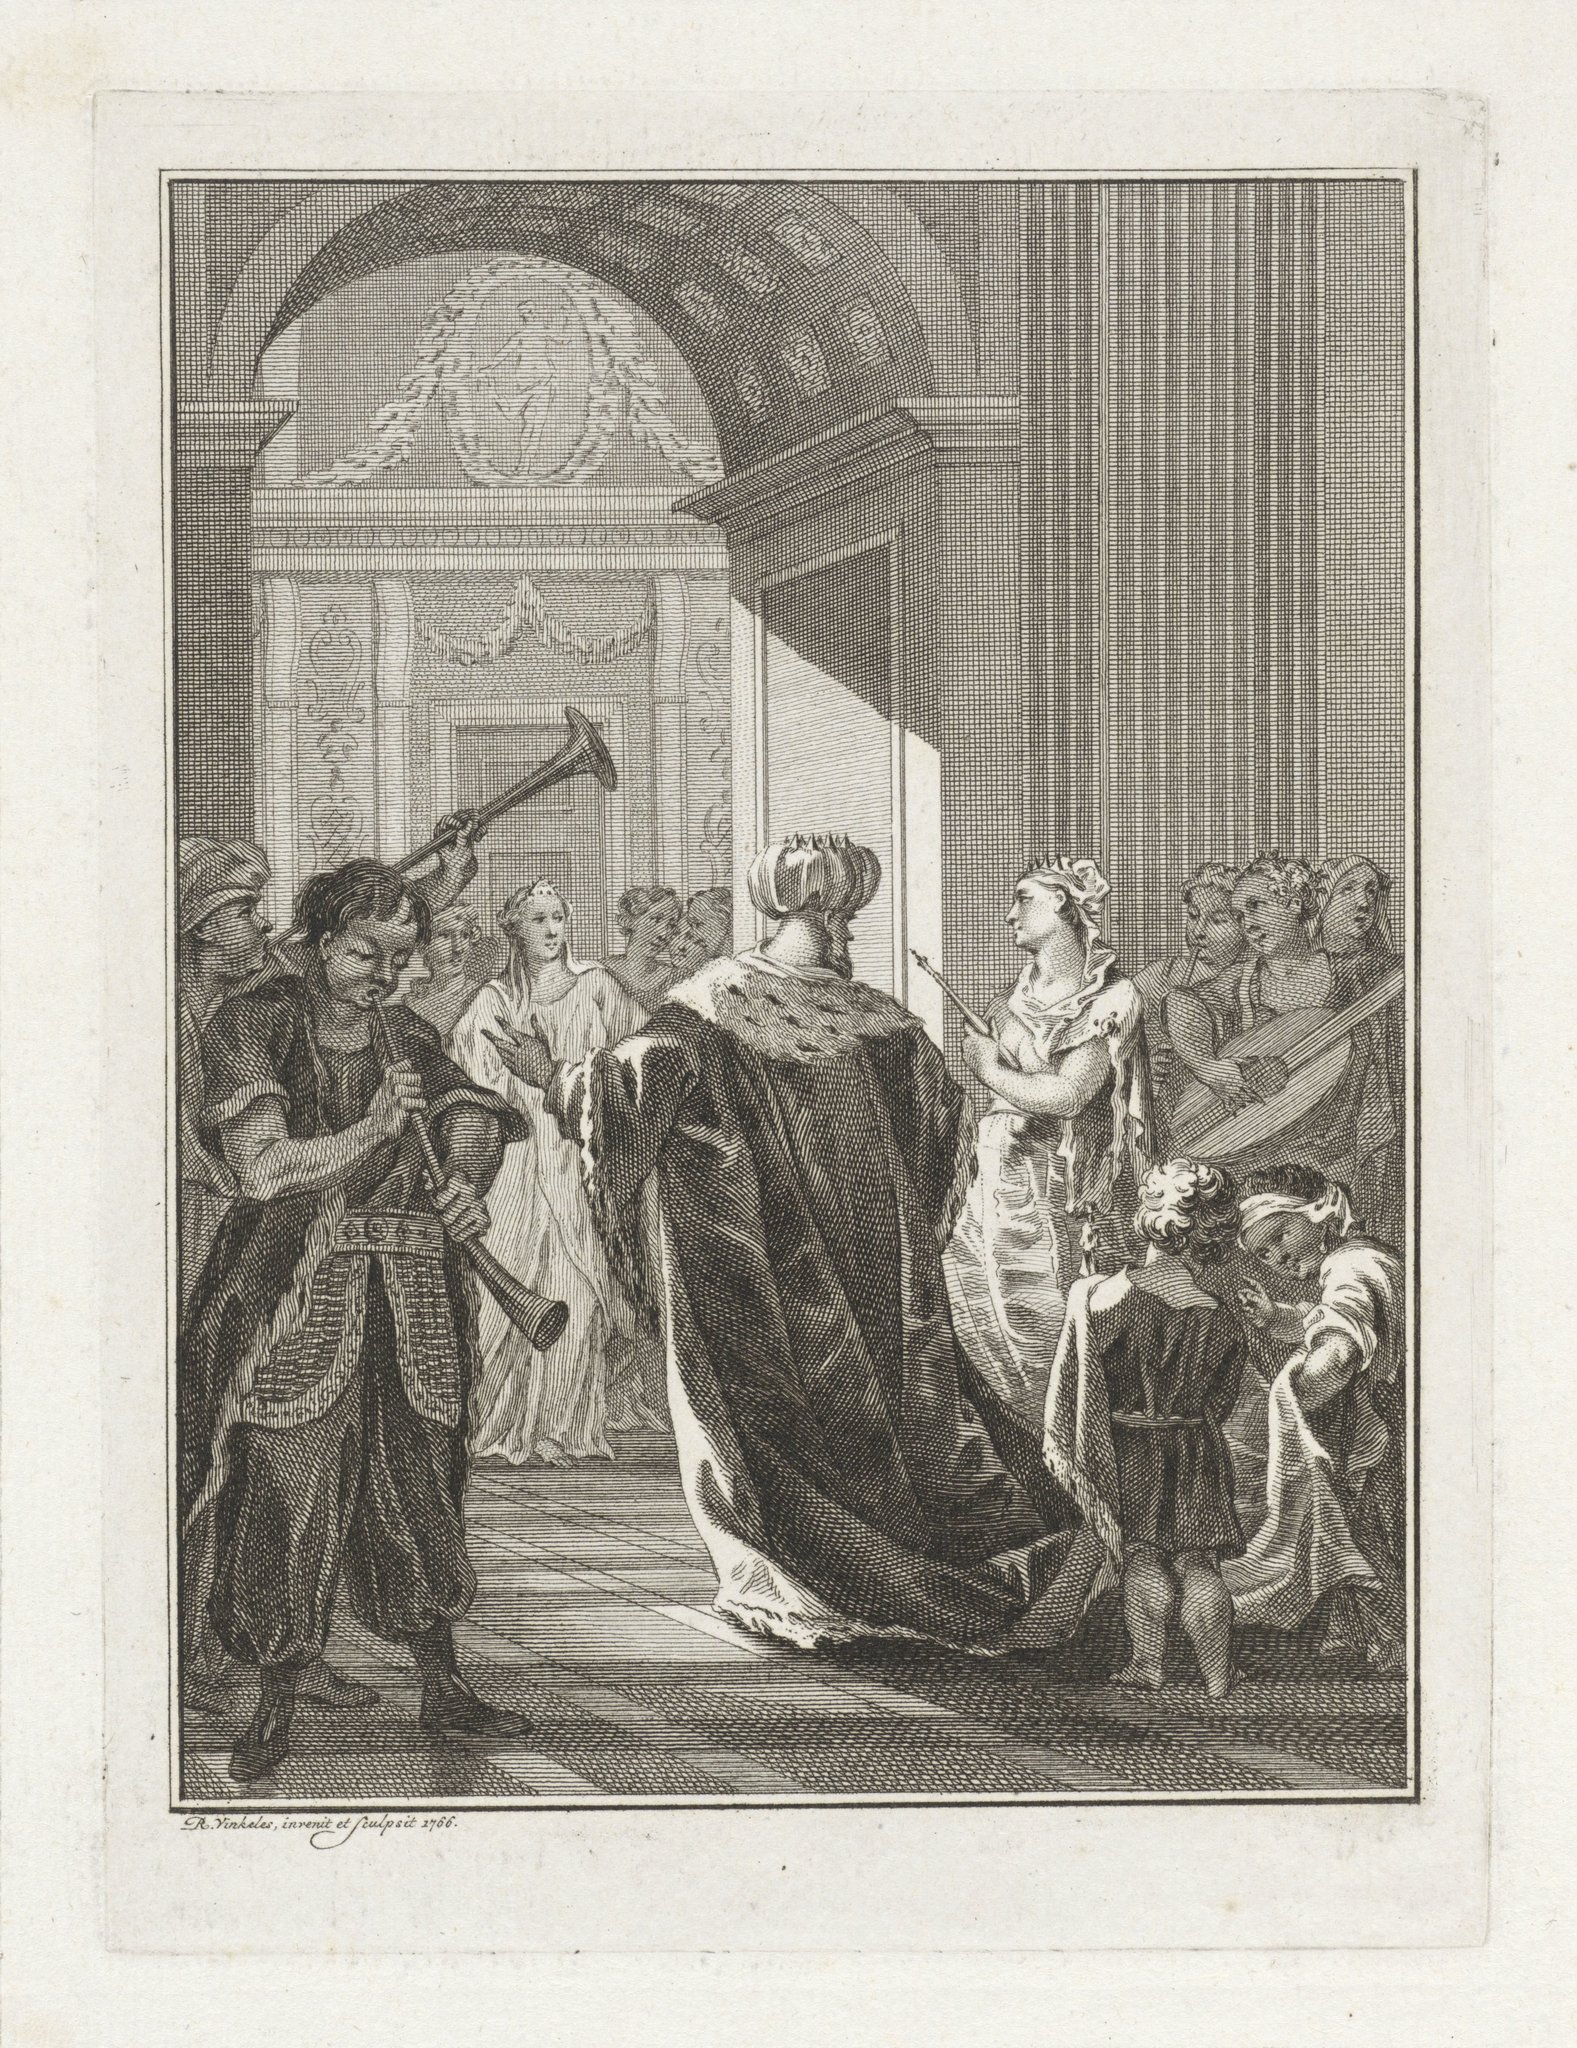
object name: print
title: Salomo en de koningin van Seba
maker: reinier vinkeles (i)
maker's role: draughtsman, print maker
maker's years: 1741-1816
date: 1766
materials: paper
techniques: engraving, etching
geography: amsterdam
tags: homage to solomon: the queen of sheba gives solomon gold, precious stones and spices, the queen of sheba before solomon, testing him with questions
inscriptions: collector's mark: Lugt 240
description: De koningin van Seba komt aan bij het hof van koning Salomo. De koningin van Seba test de wijsheid van Salomo door hem allerlei raadsels voor te leggen.